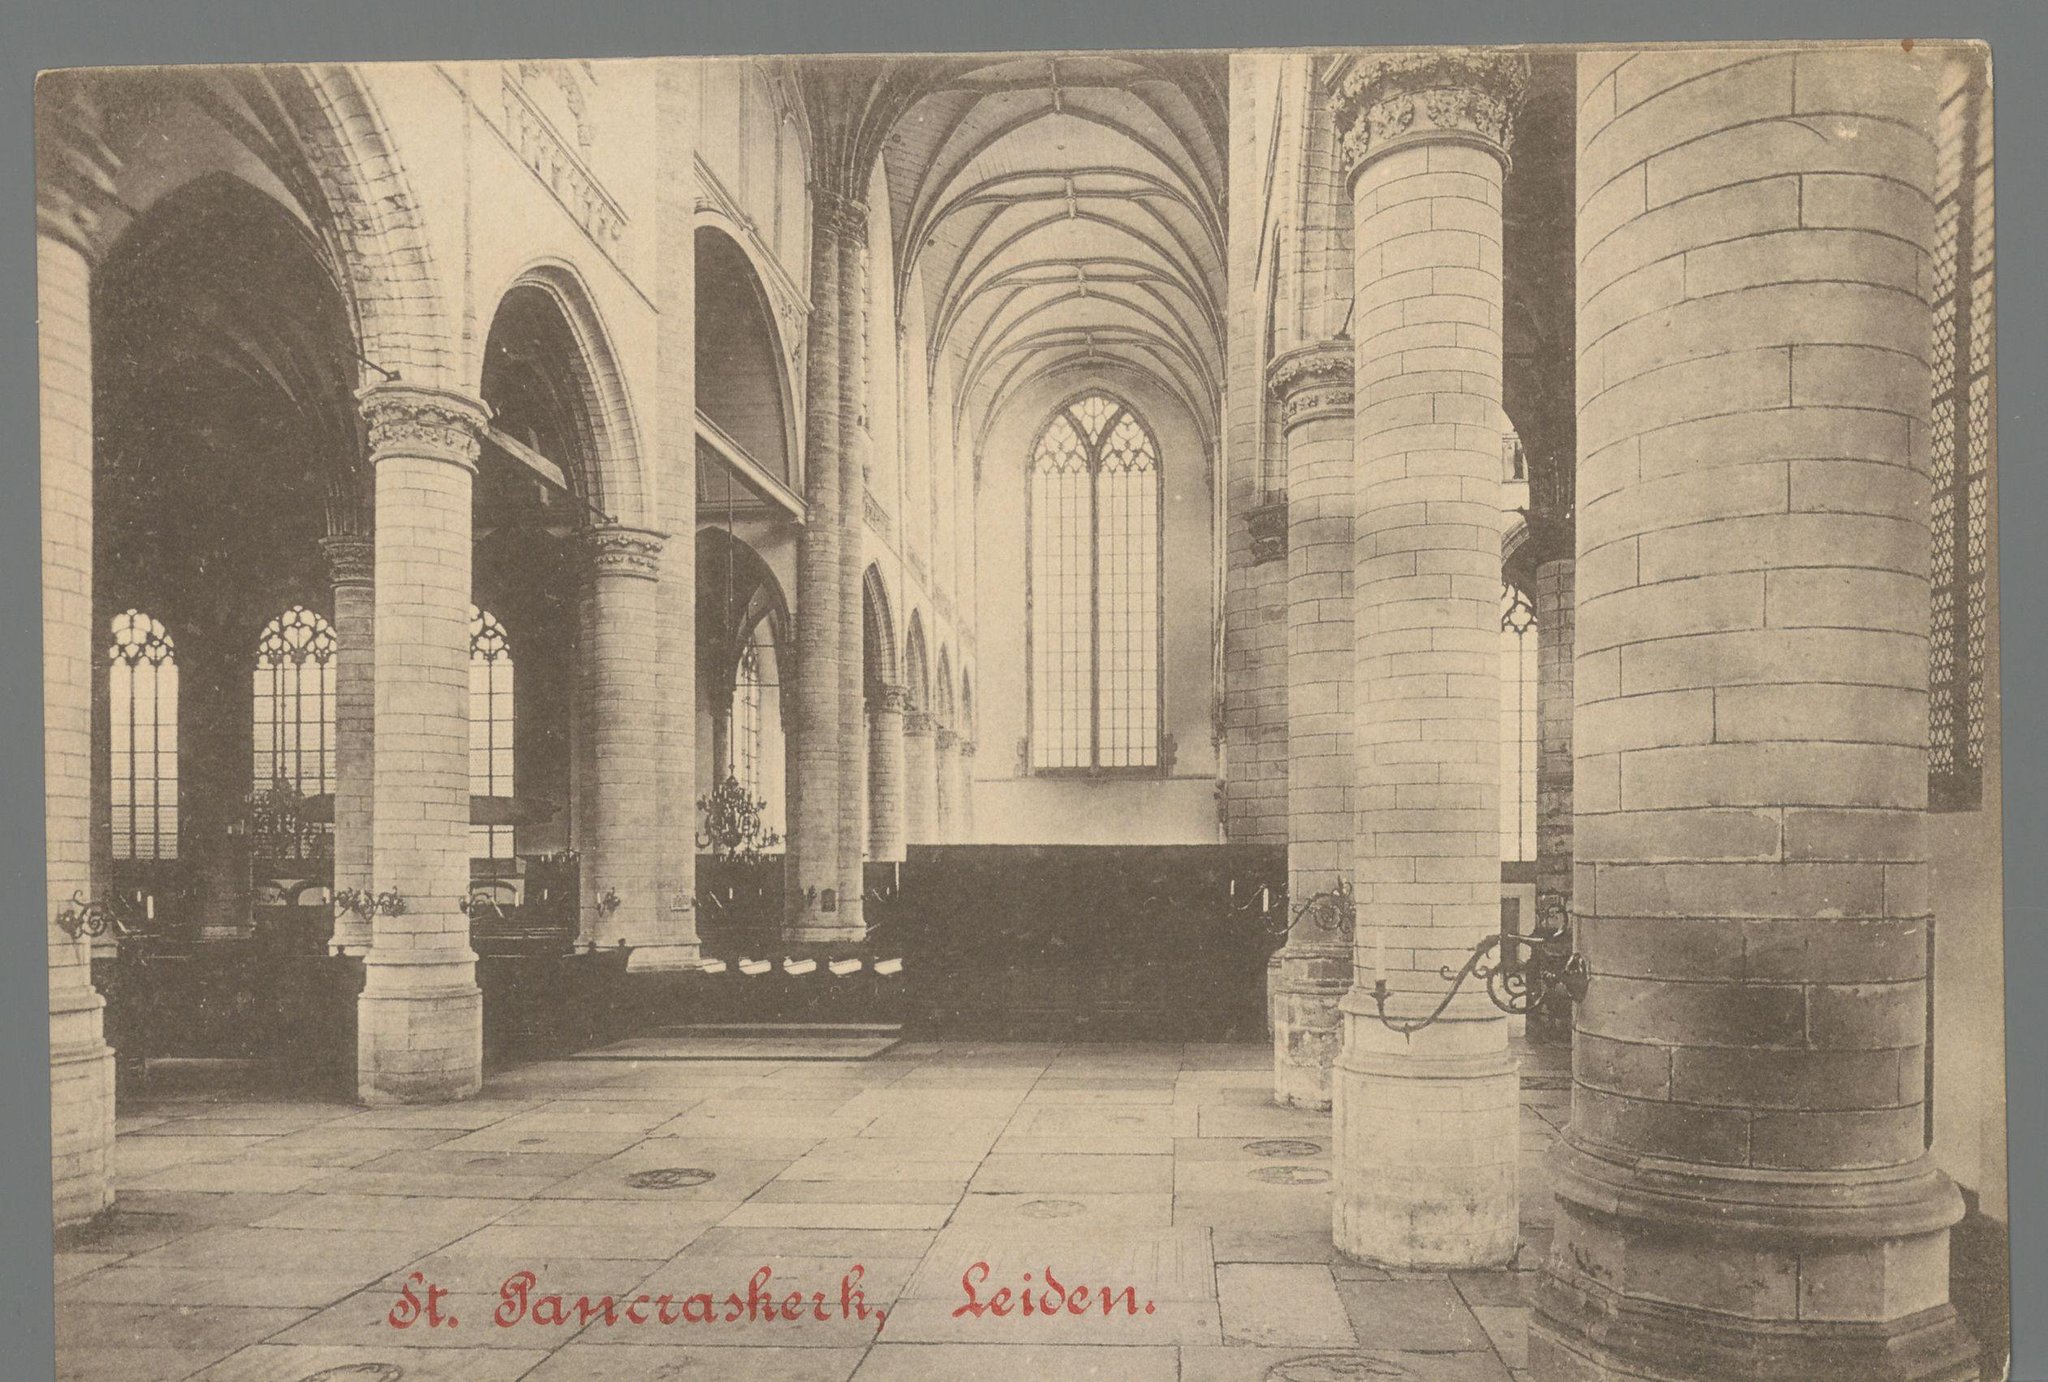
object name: photomechanical print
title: St. Pancraskerk, Leiden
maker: Anonymous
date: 1905-1930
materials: cardboard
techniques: photograph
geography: leiden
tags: interior of church